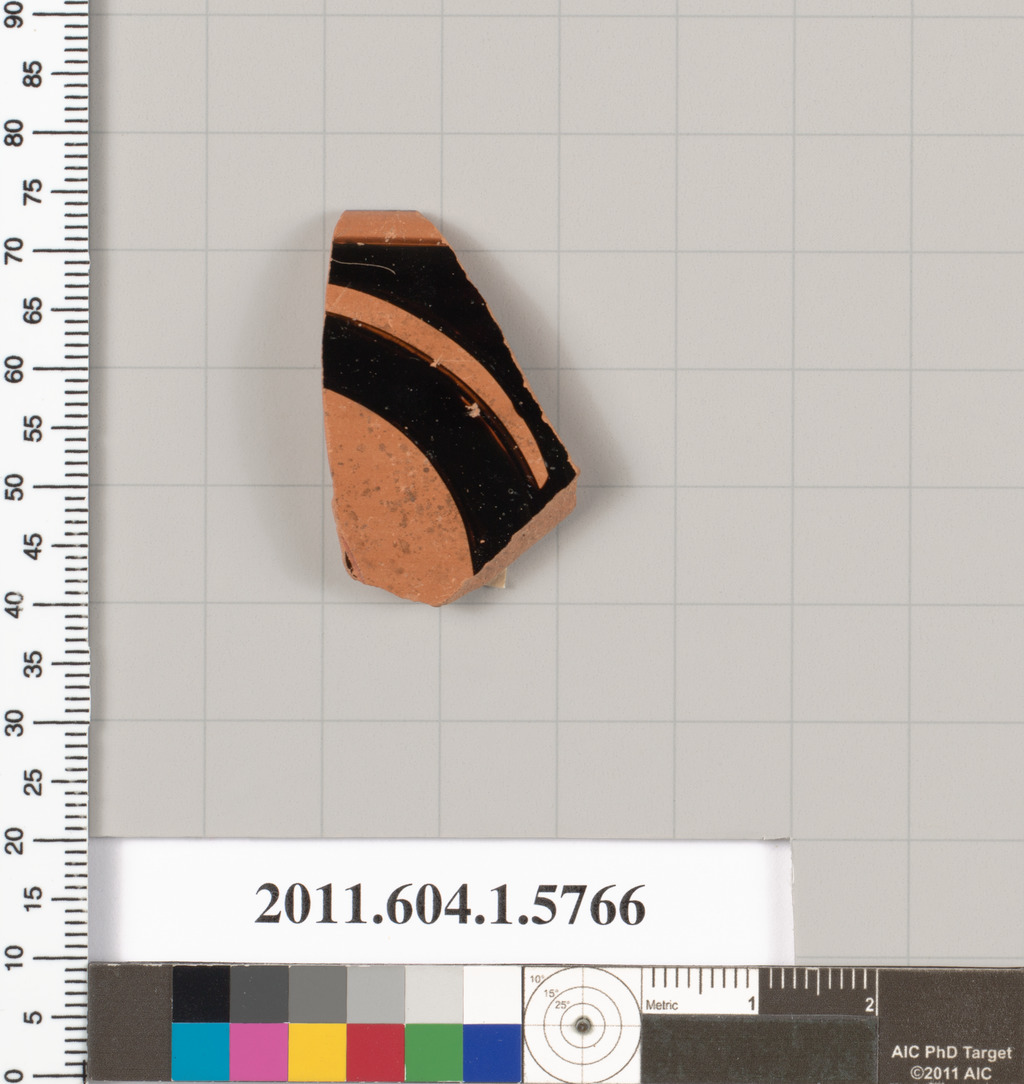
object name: kylix fragment, eye cup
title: Terracotta rim fragment of a kylix: eye-cup (drinking cup)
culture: greek, attic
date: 525-510 BCE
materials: terracotta